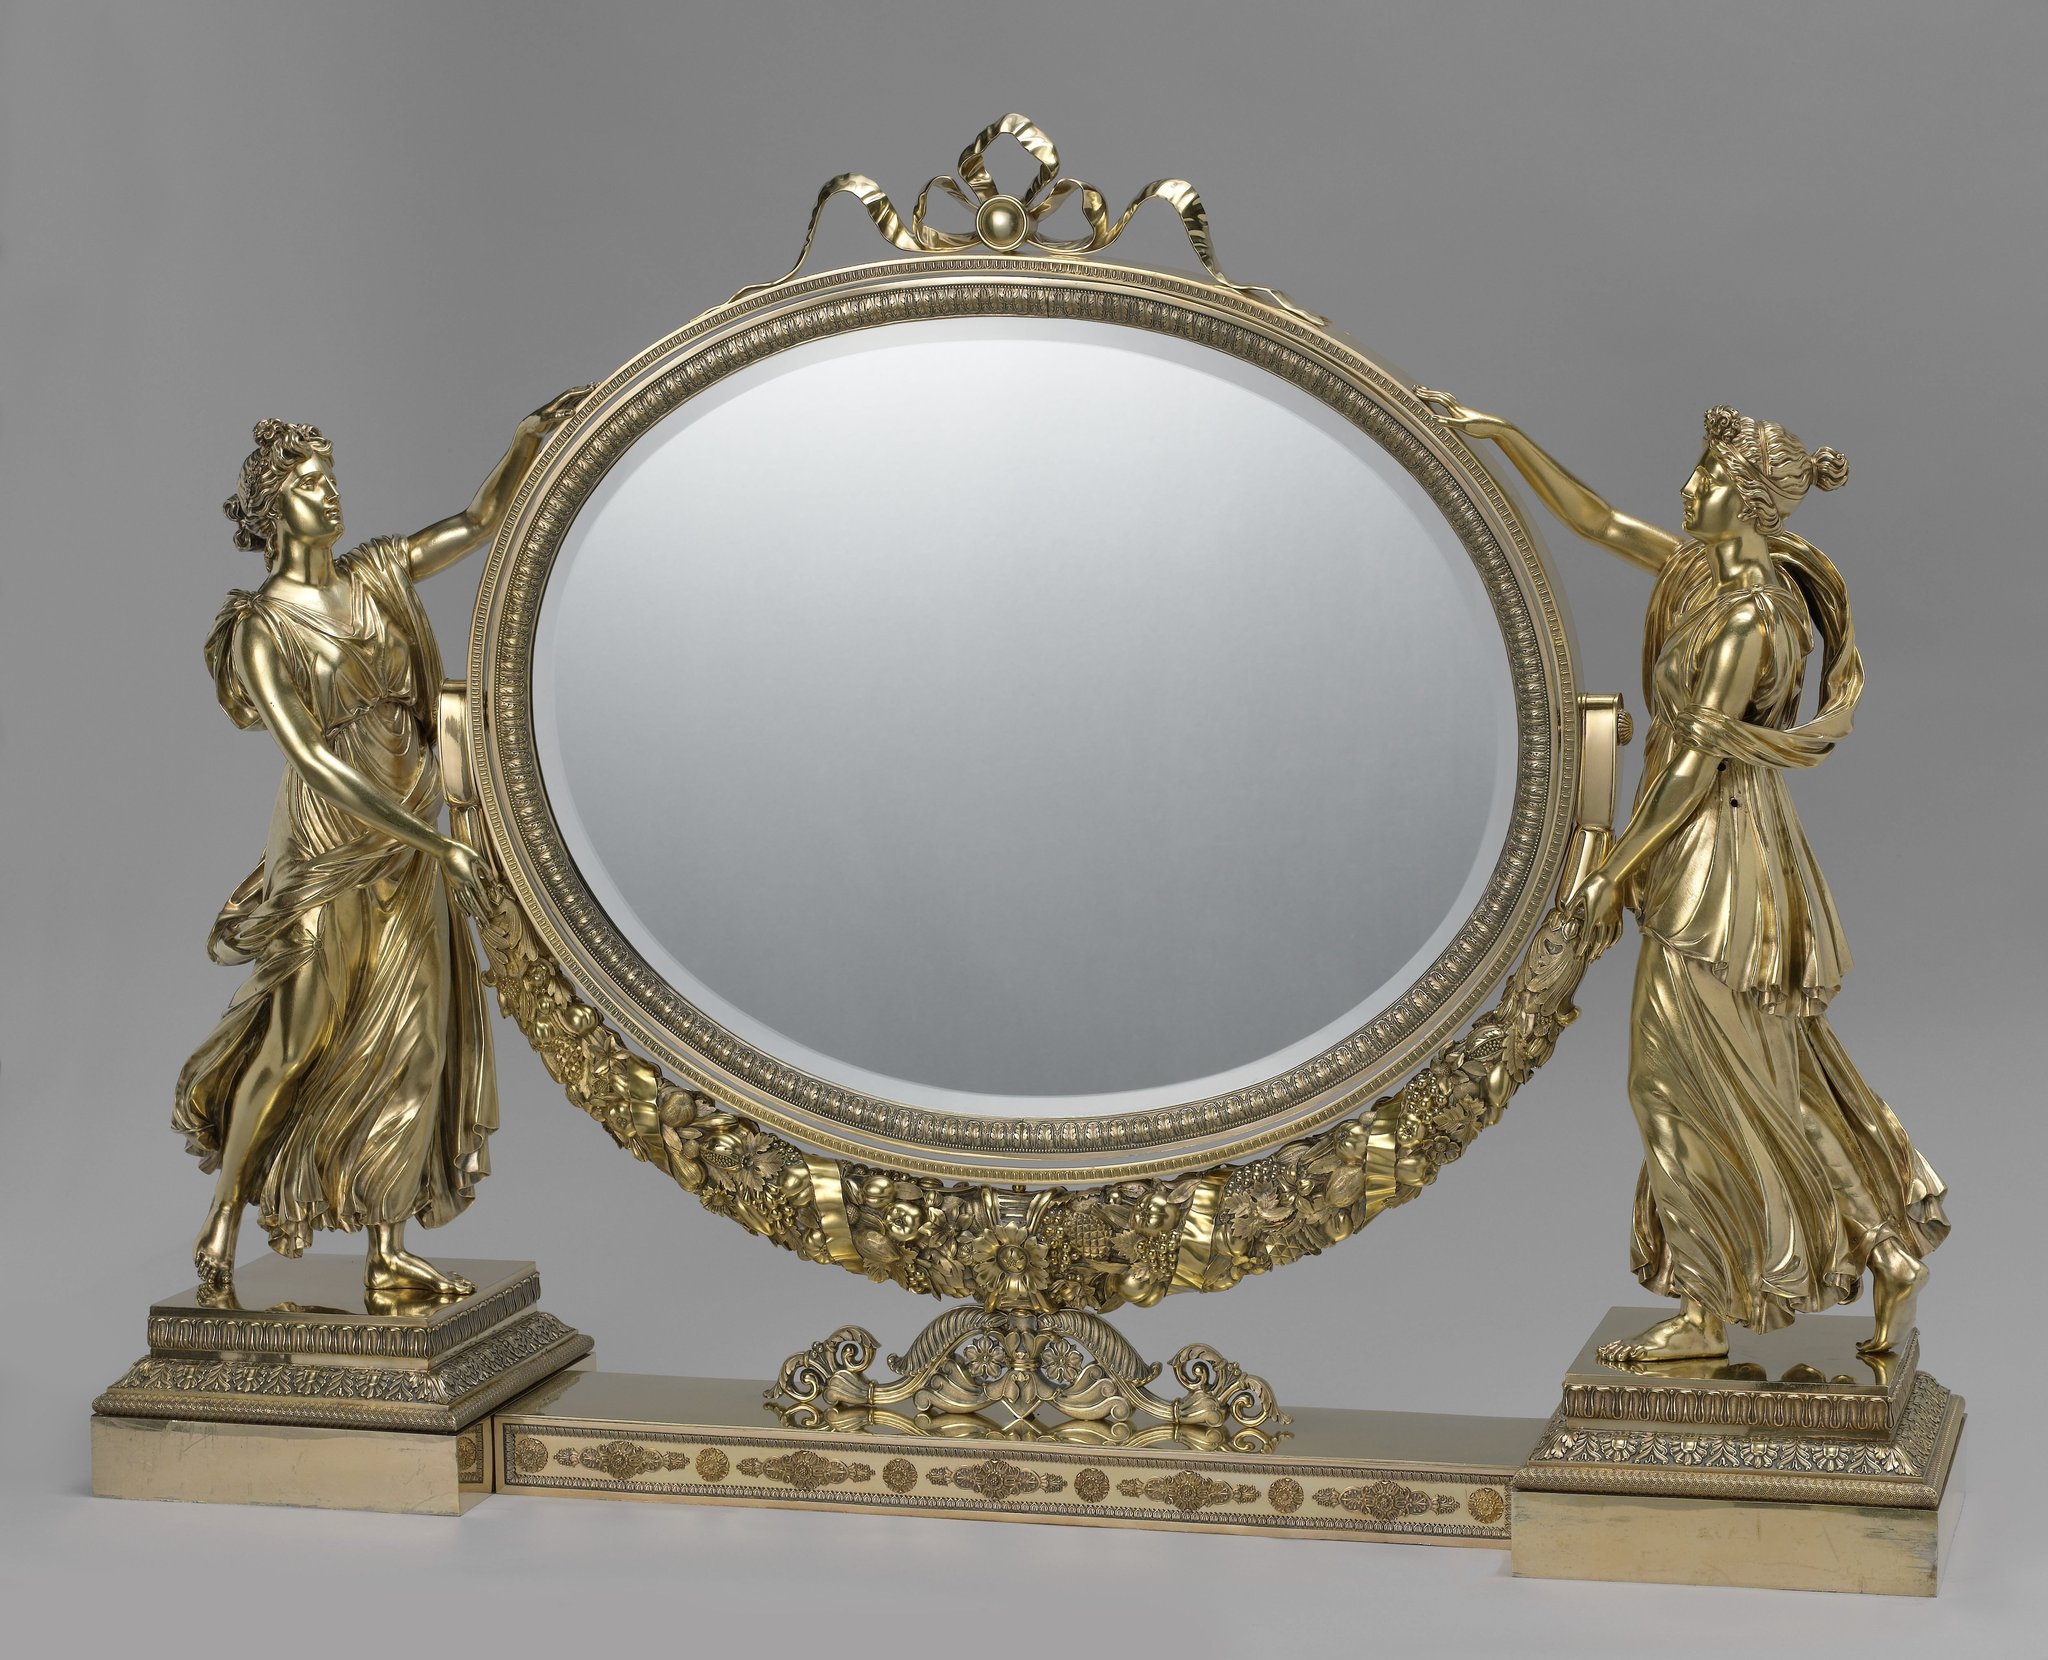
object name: dressing glass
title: Toilet Mirror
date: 1828-1829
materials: amalgam, glass, silver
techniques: gilding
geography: brussels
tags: berlin, voorburg, marianne (prinses der nederlanden), standing figure - aa - female human figure, ornament ~ festoon, garland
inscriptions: maker's mark, retailer's mark, alloy mark, assay office mark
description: When Princess Marianne married, her father King William I gifted her a magnificent toilet crafted in the Empire style, with figures based on antiquity. For this commission, the king engaged the best artisans in the southern Netherlands at the time: the goldsmith Dutalis in Brussels and the sculptor Royer from Mechelen. The set comprised a jewellery box, several gilded boxes, and this mirror as a showpiece.